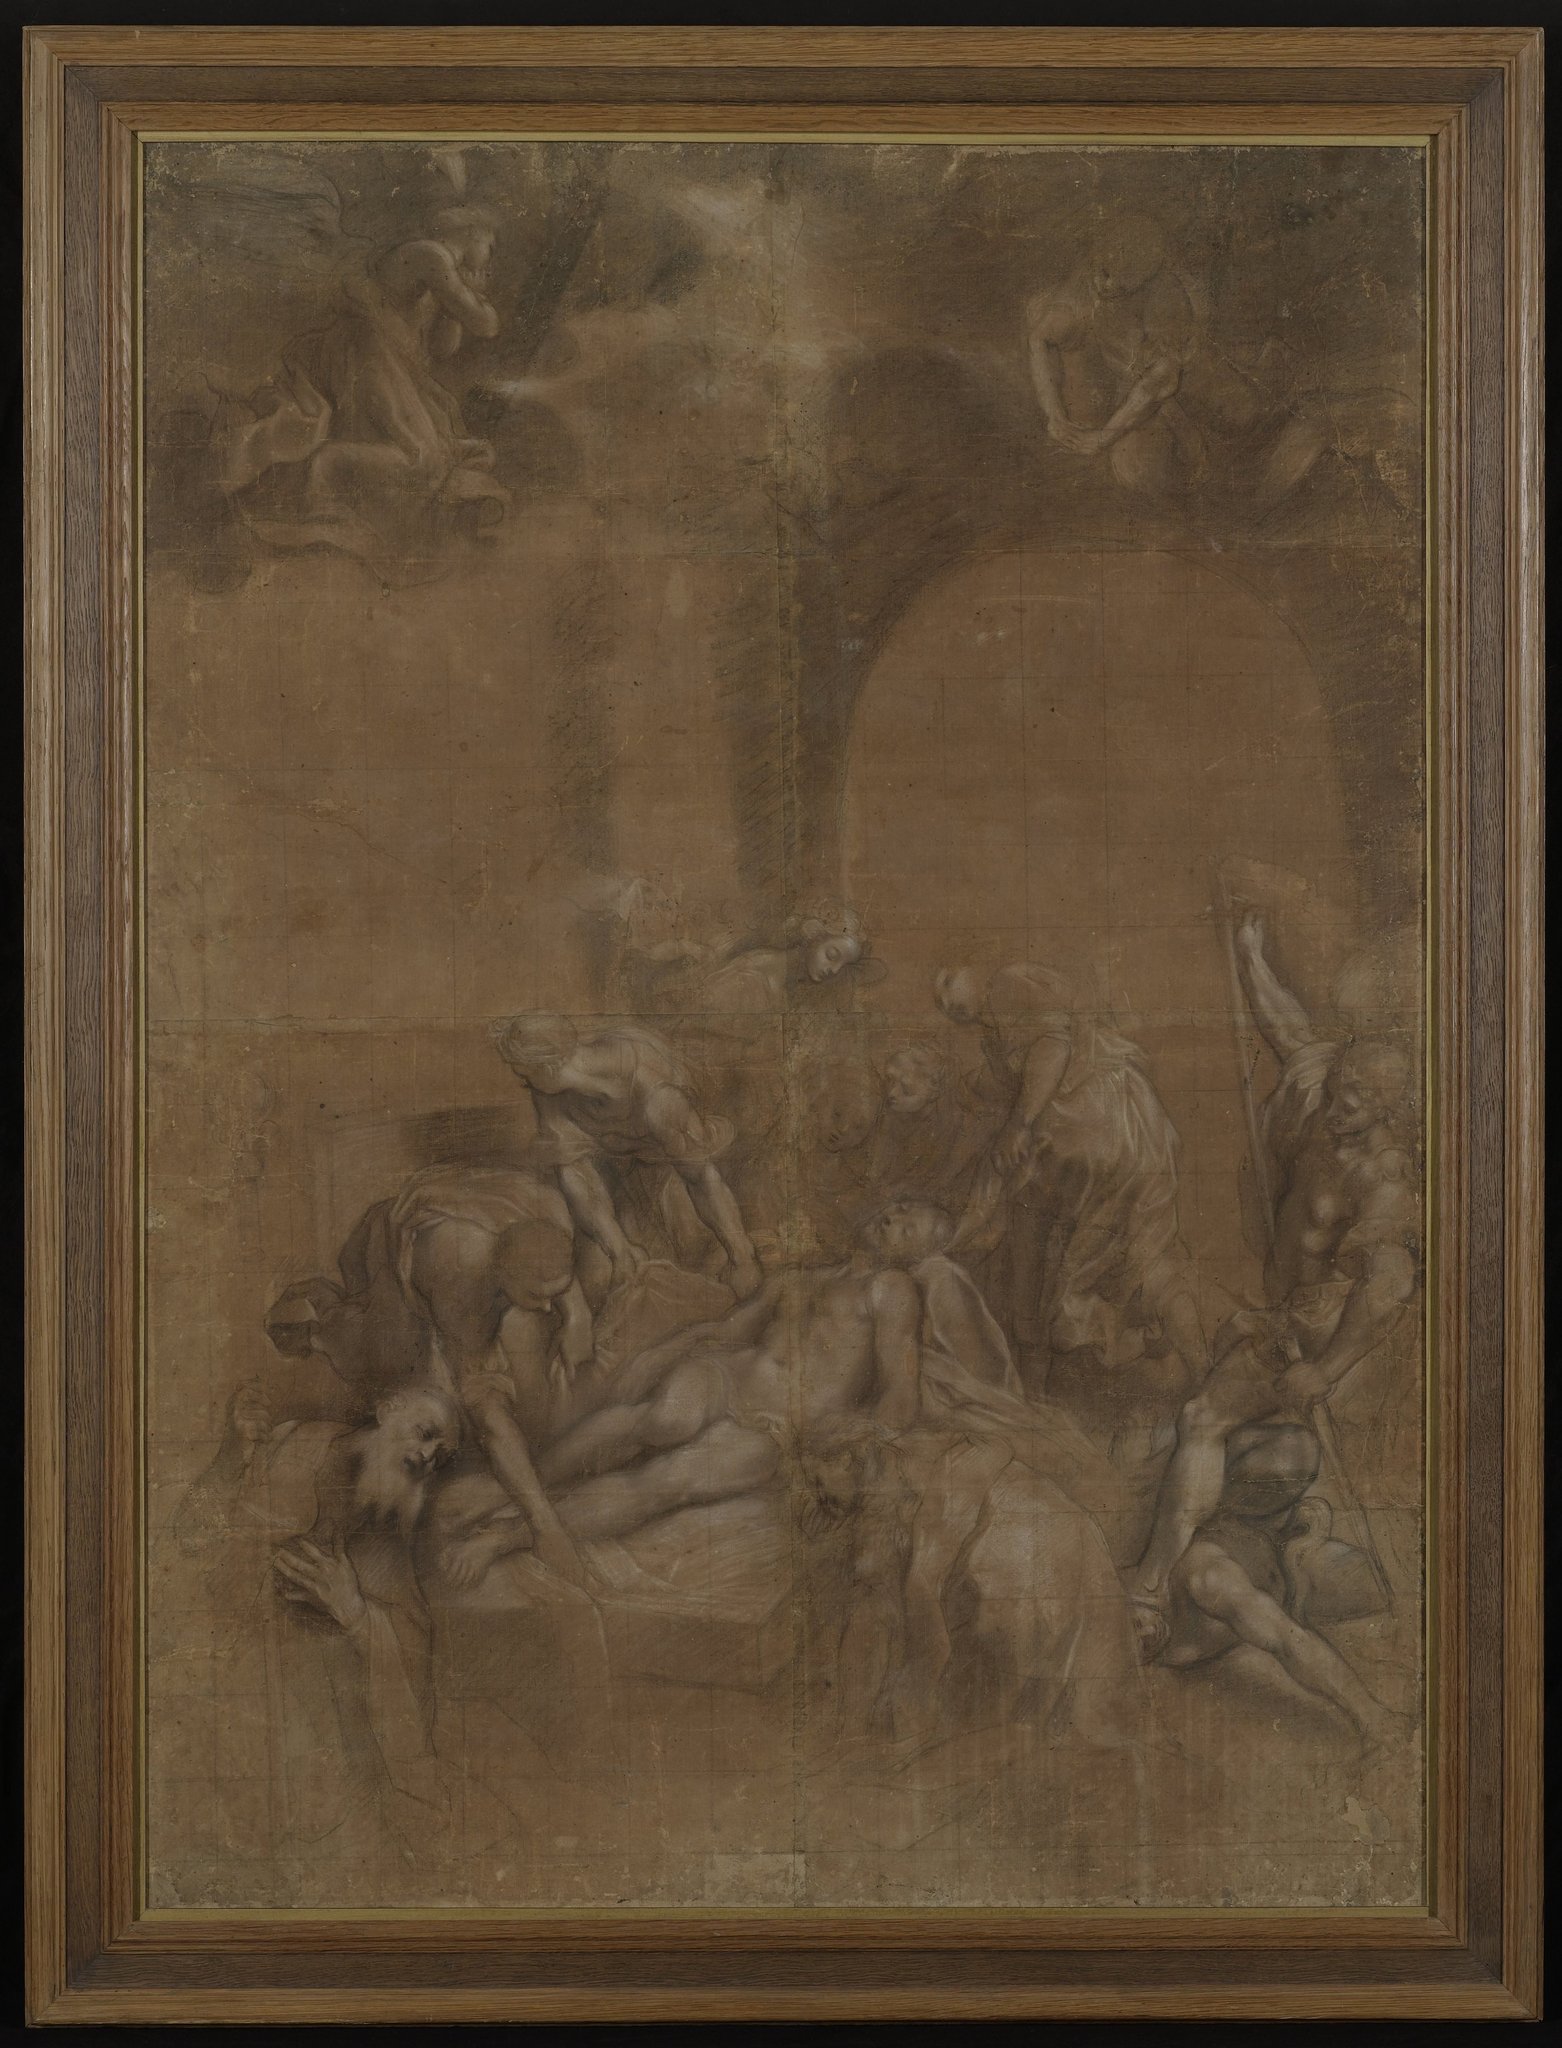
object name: drawing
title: Bewening van de dode Christus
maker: federico barocci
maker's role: draughtsman, painter, print maker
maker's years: 1528-1612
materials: chalk, charcoal, linen, paper, pastel, wood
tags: lamentation over the dead christ by his relatives and friends (christ usually without crown of thorns)